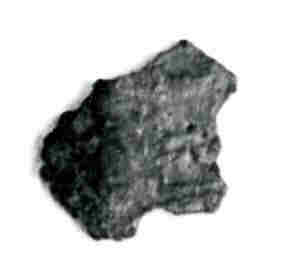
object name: coin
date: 401-1400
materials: copper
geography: iran